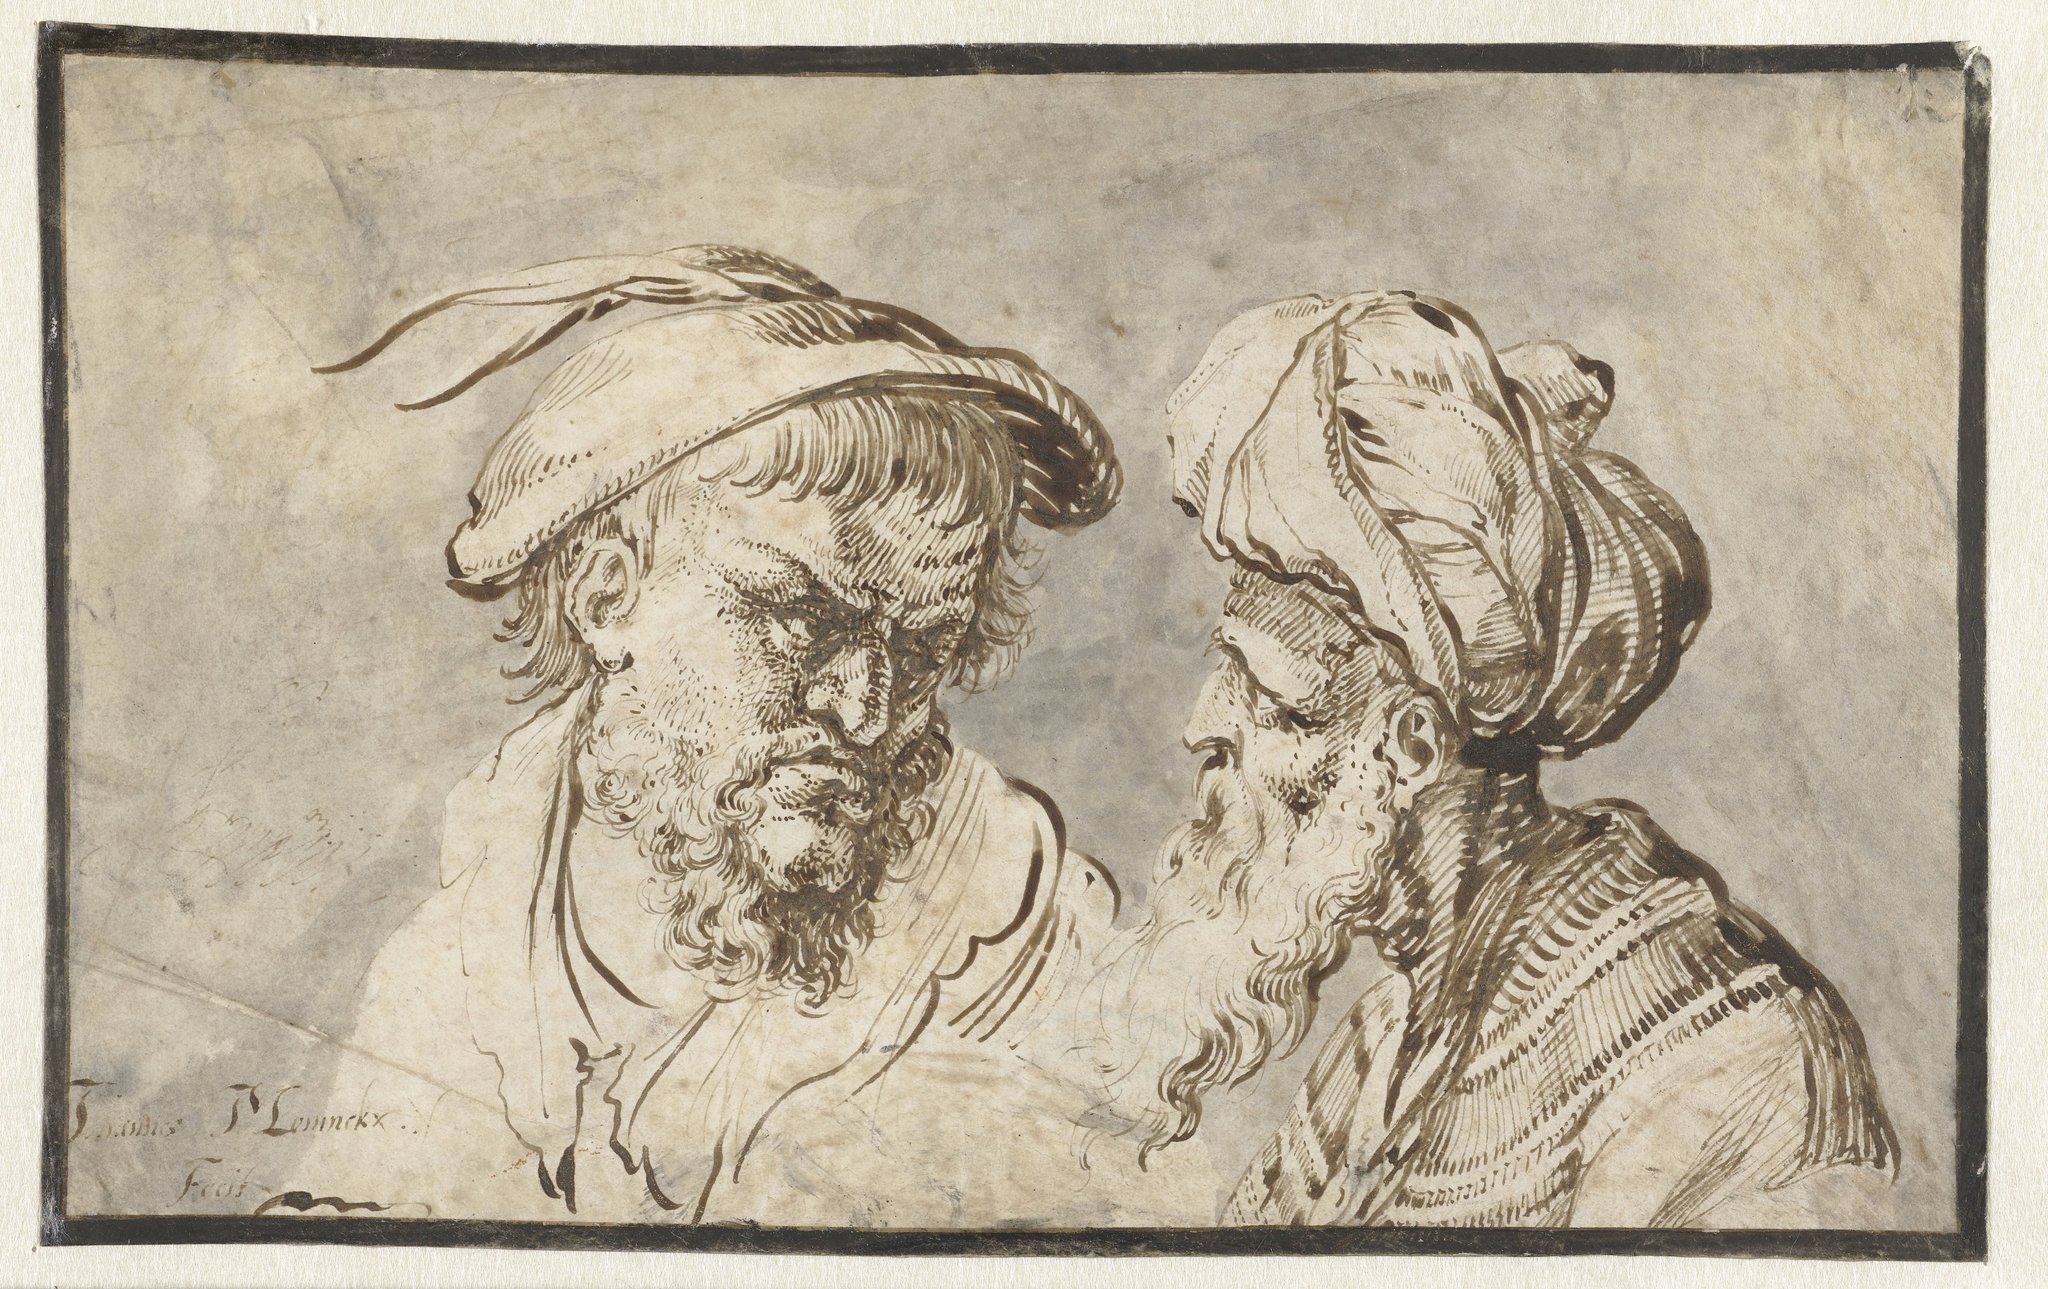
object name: drawing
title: Twee hoofden van Oosterlingen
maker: jan moninckx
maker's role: draughtsman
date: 1600-1699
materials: ink, parchment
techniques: brush, pen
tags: asiatic races and peoples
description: Twee mannenhoofden, beiden met baard. Het linkerhoofd is gedekt met een platte hoed met twee veren, het rechter draagt een tulband.